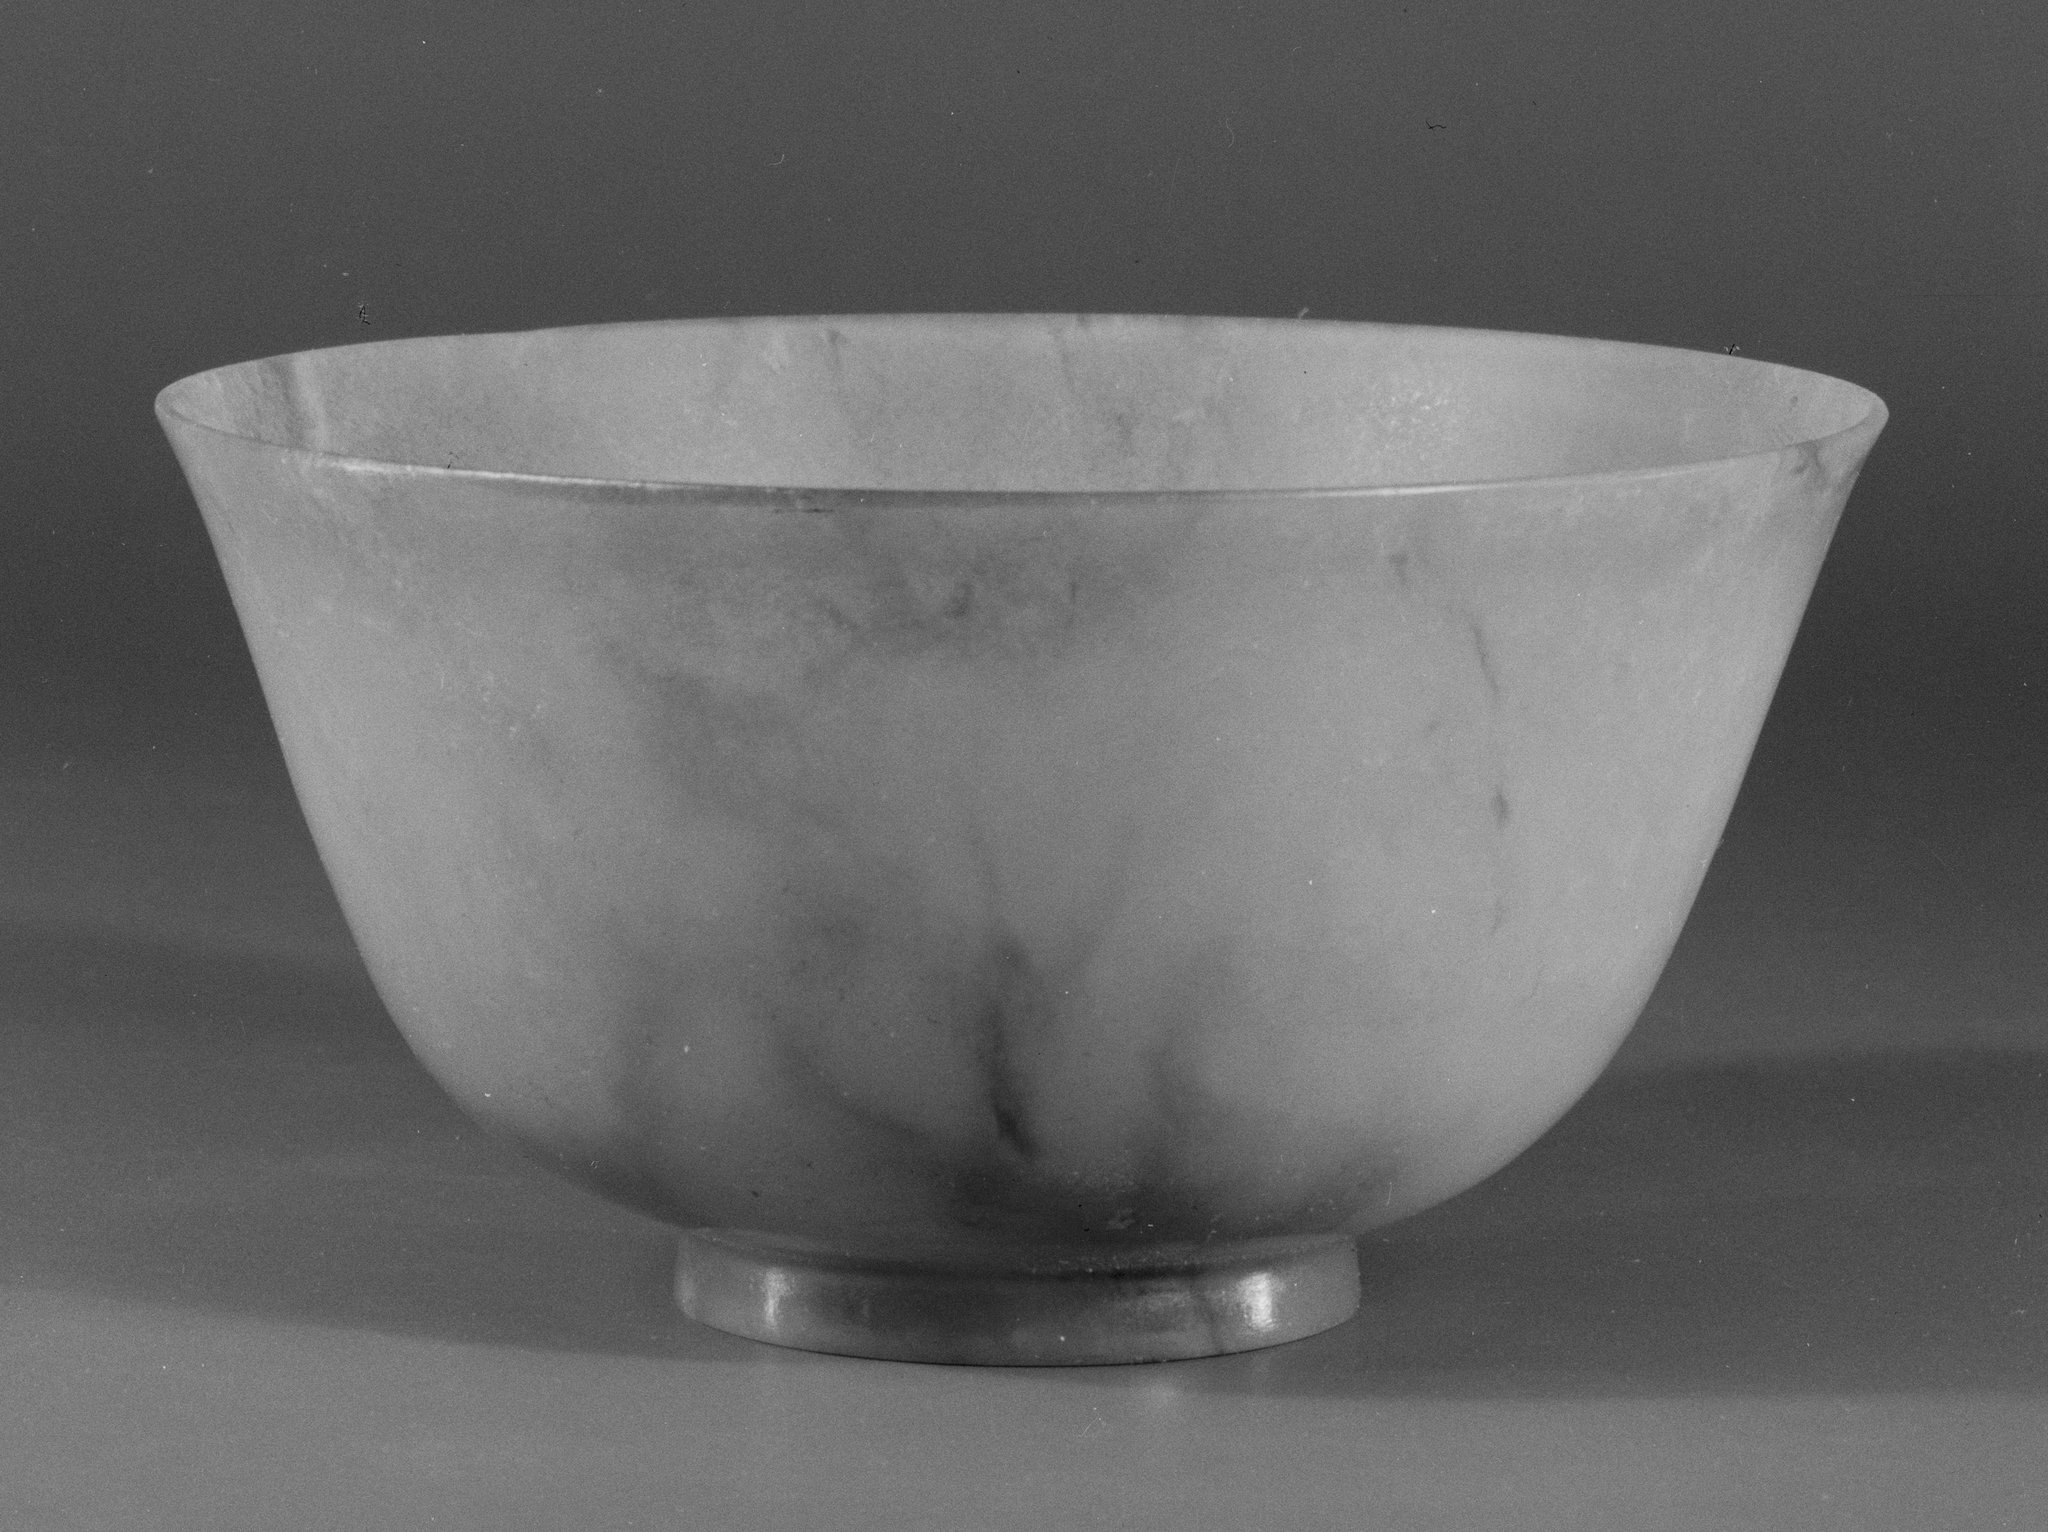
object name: bowl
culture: chinese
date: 1901-2000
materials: jade